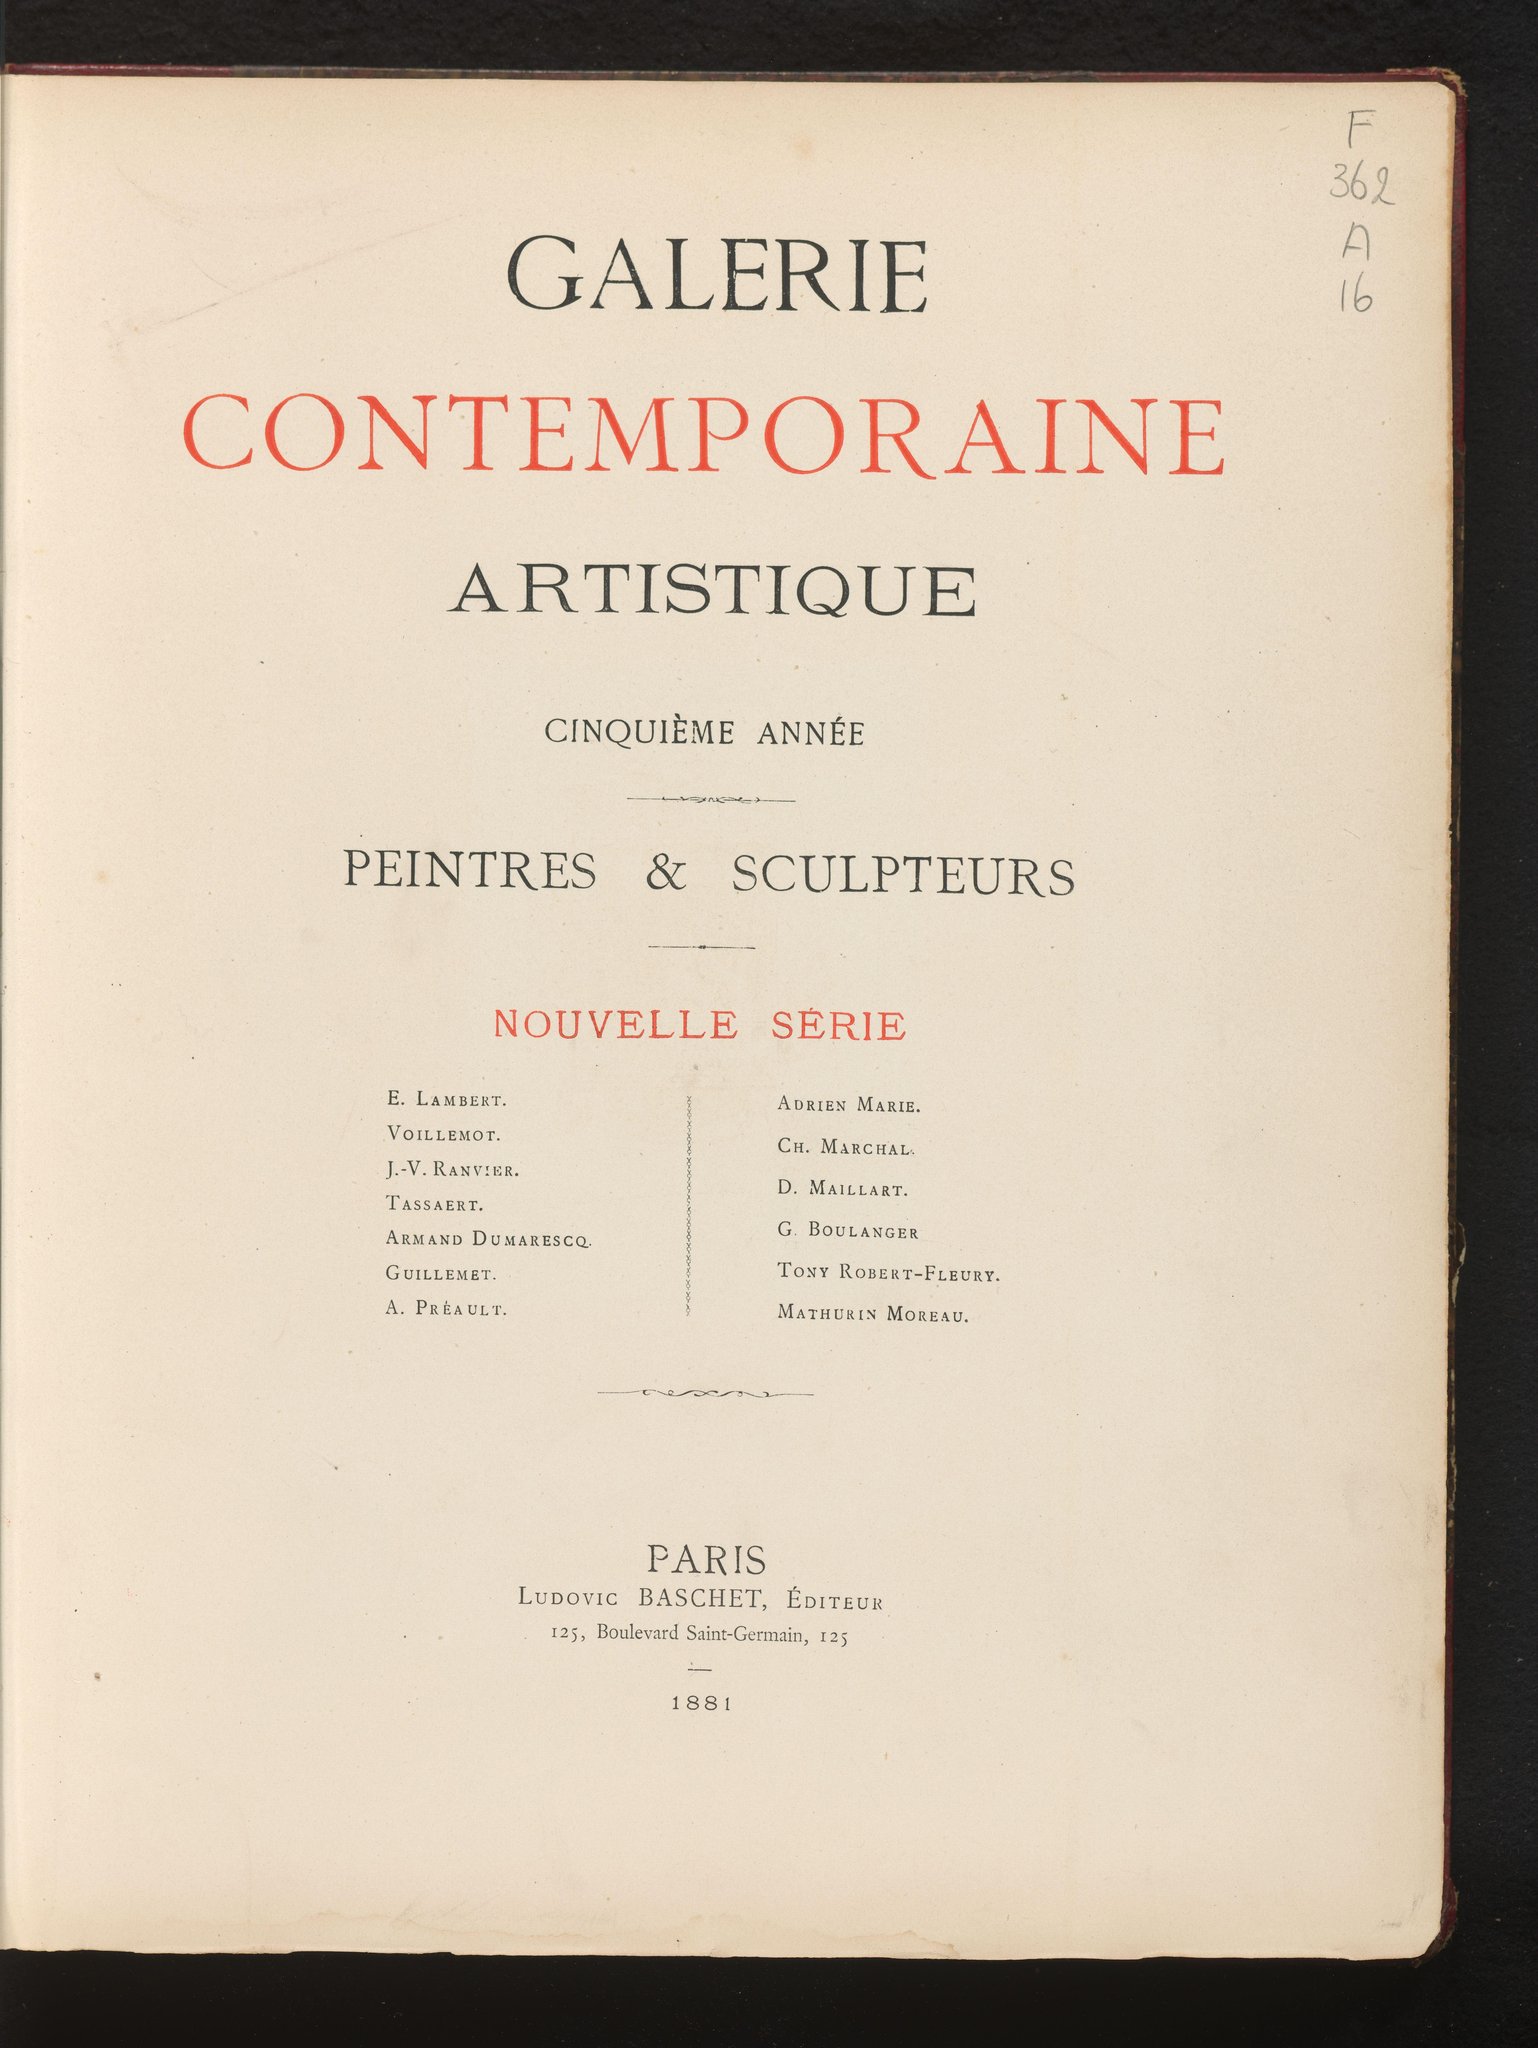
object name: book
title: Galerie contemporaine artistique : peintres et sculpteurs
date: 1881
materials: cardboard, leather, paper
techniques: marbled paper, printing, woodburytype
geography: paris